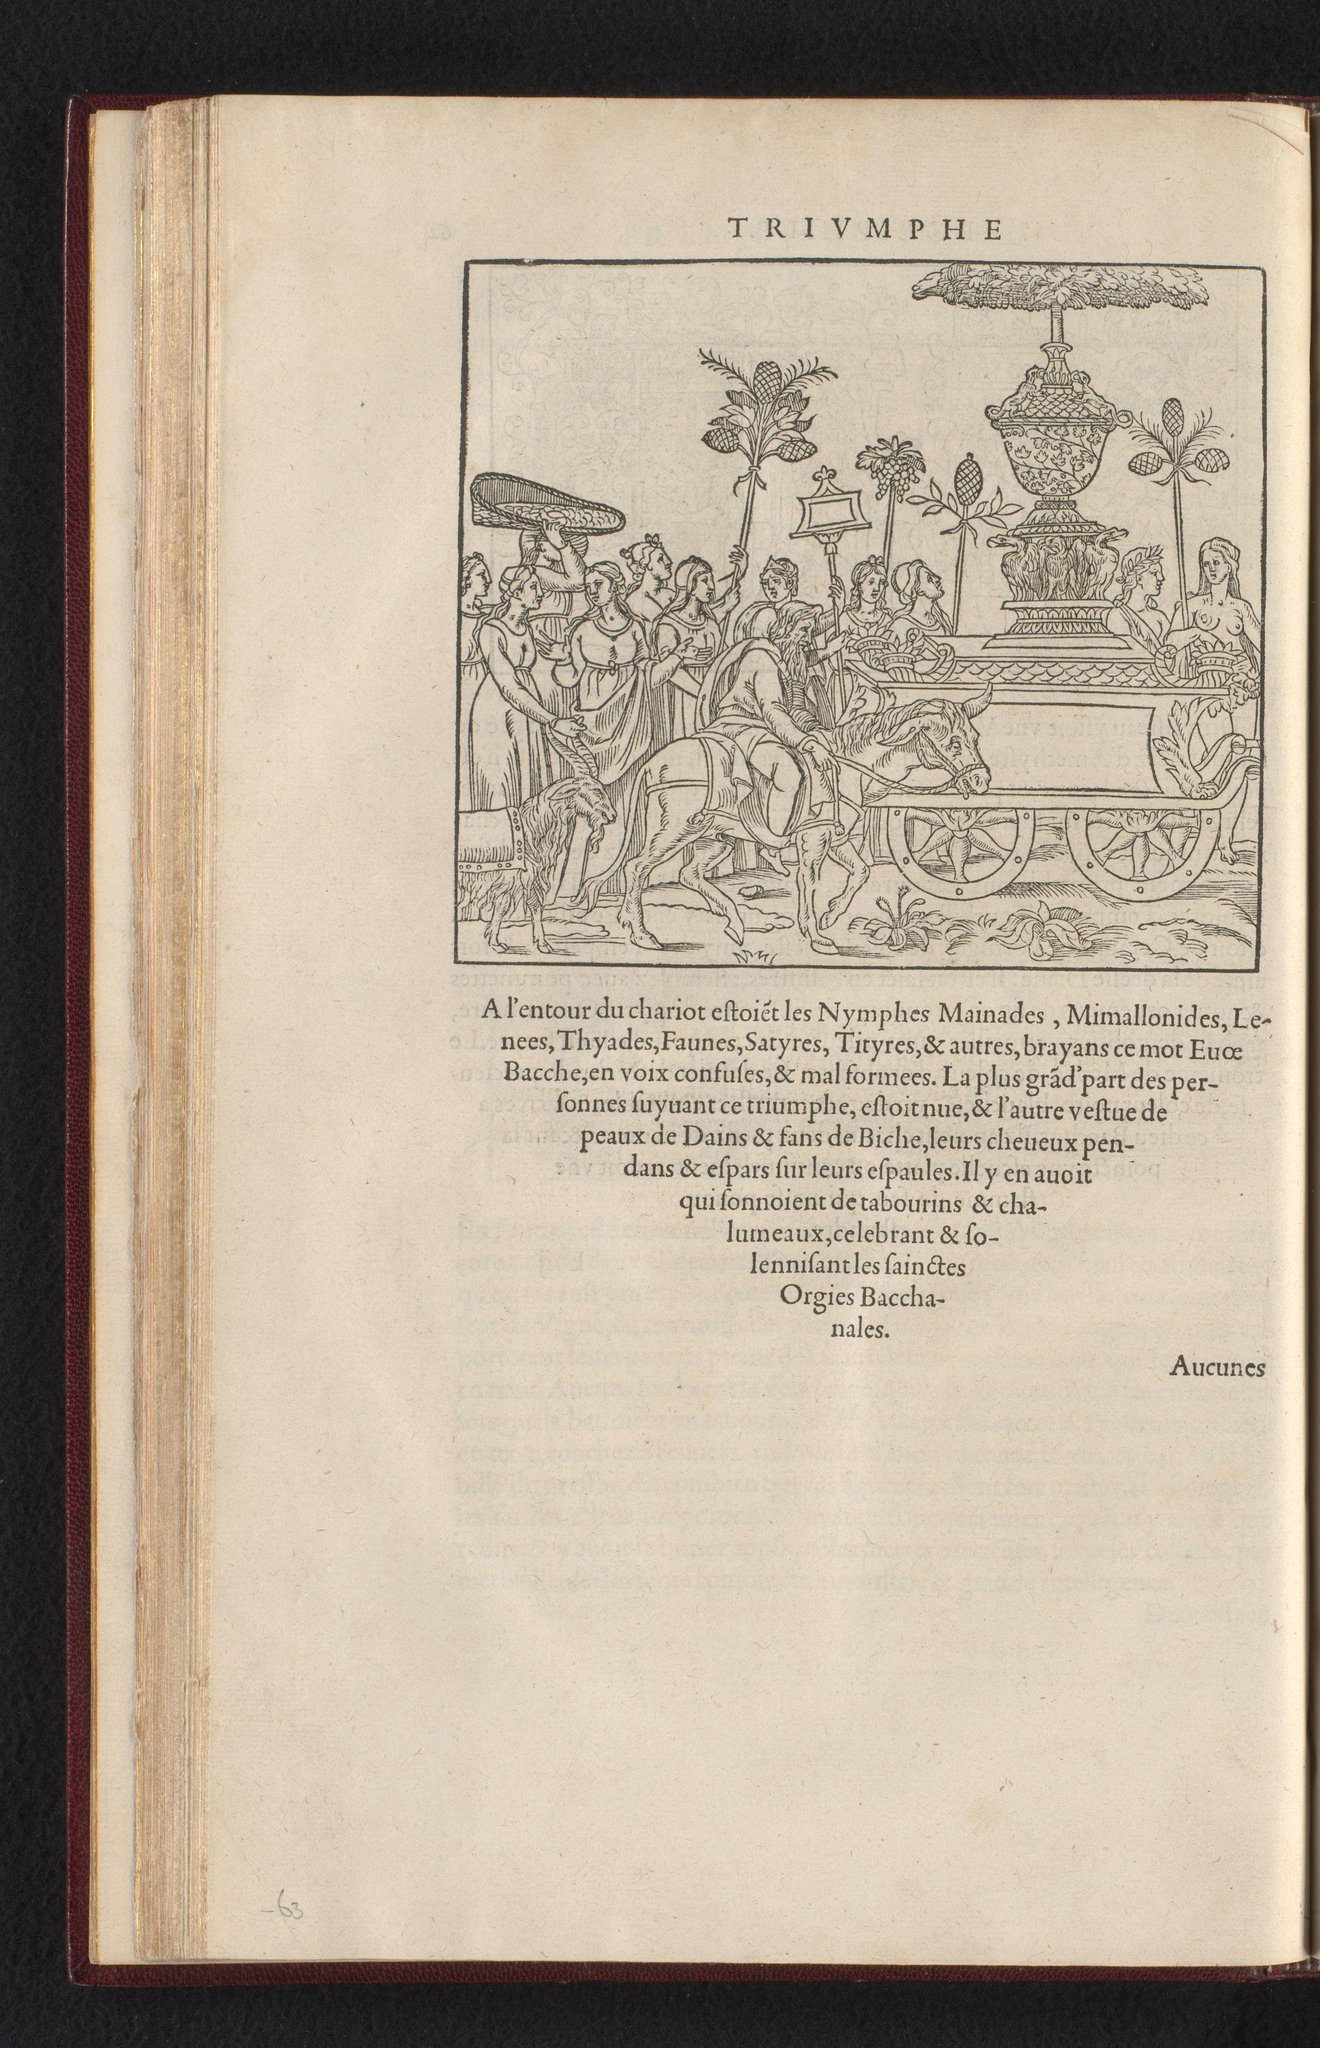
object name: book illustration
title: Triomfwagen met Bacchanalische optocht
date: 1546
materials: paper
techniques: letterpress printing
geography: paris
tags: ass, donkey, chariot, triumphal car, (scenes from) specific works of literature: colonna, hypnerotomachia poliphili, thiasos, i.e. bacchus' revel-rout, bacchanal without bacchus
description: Prent uit: Colonna, Francesco. Hypnerotomachie ou discours du songe de Poliphile, deduisant comme amour le combat a l'occasion de Polia. Parijs: Jacques Kerver, 1546, verso fol. 62.